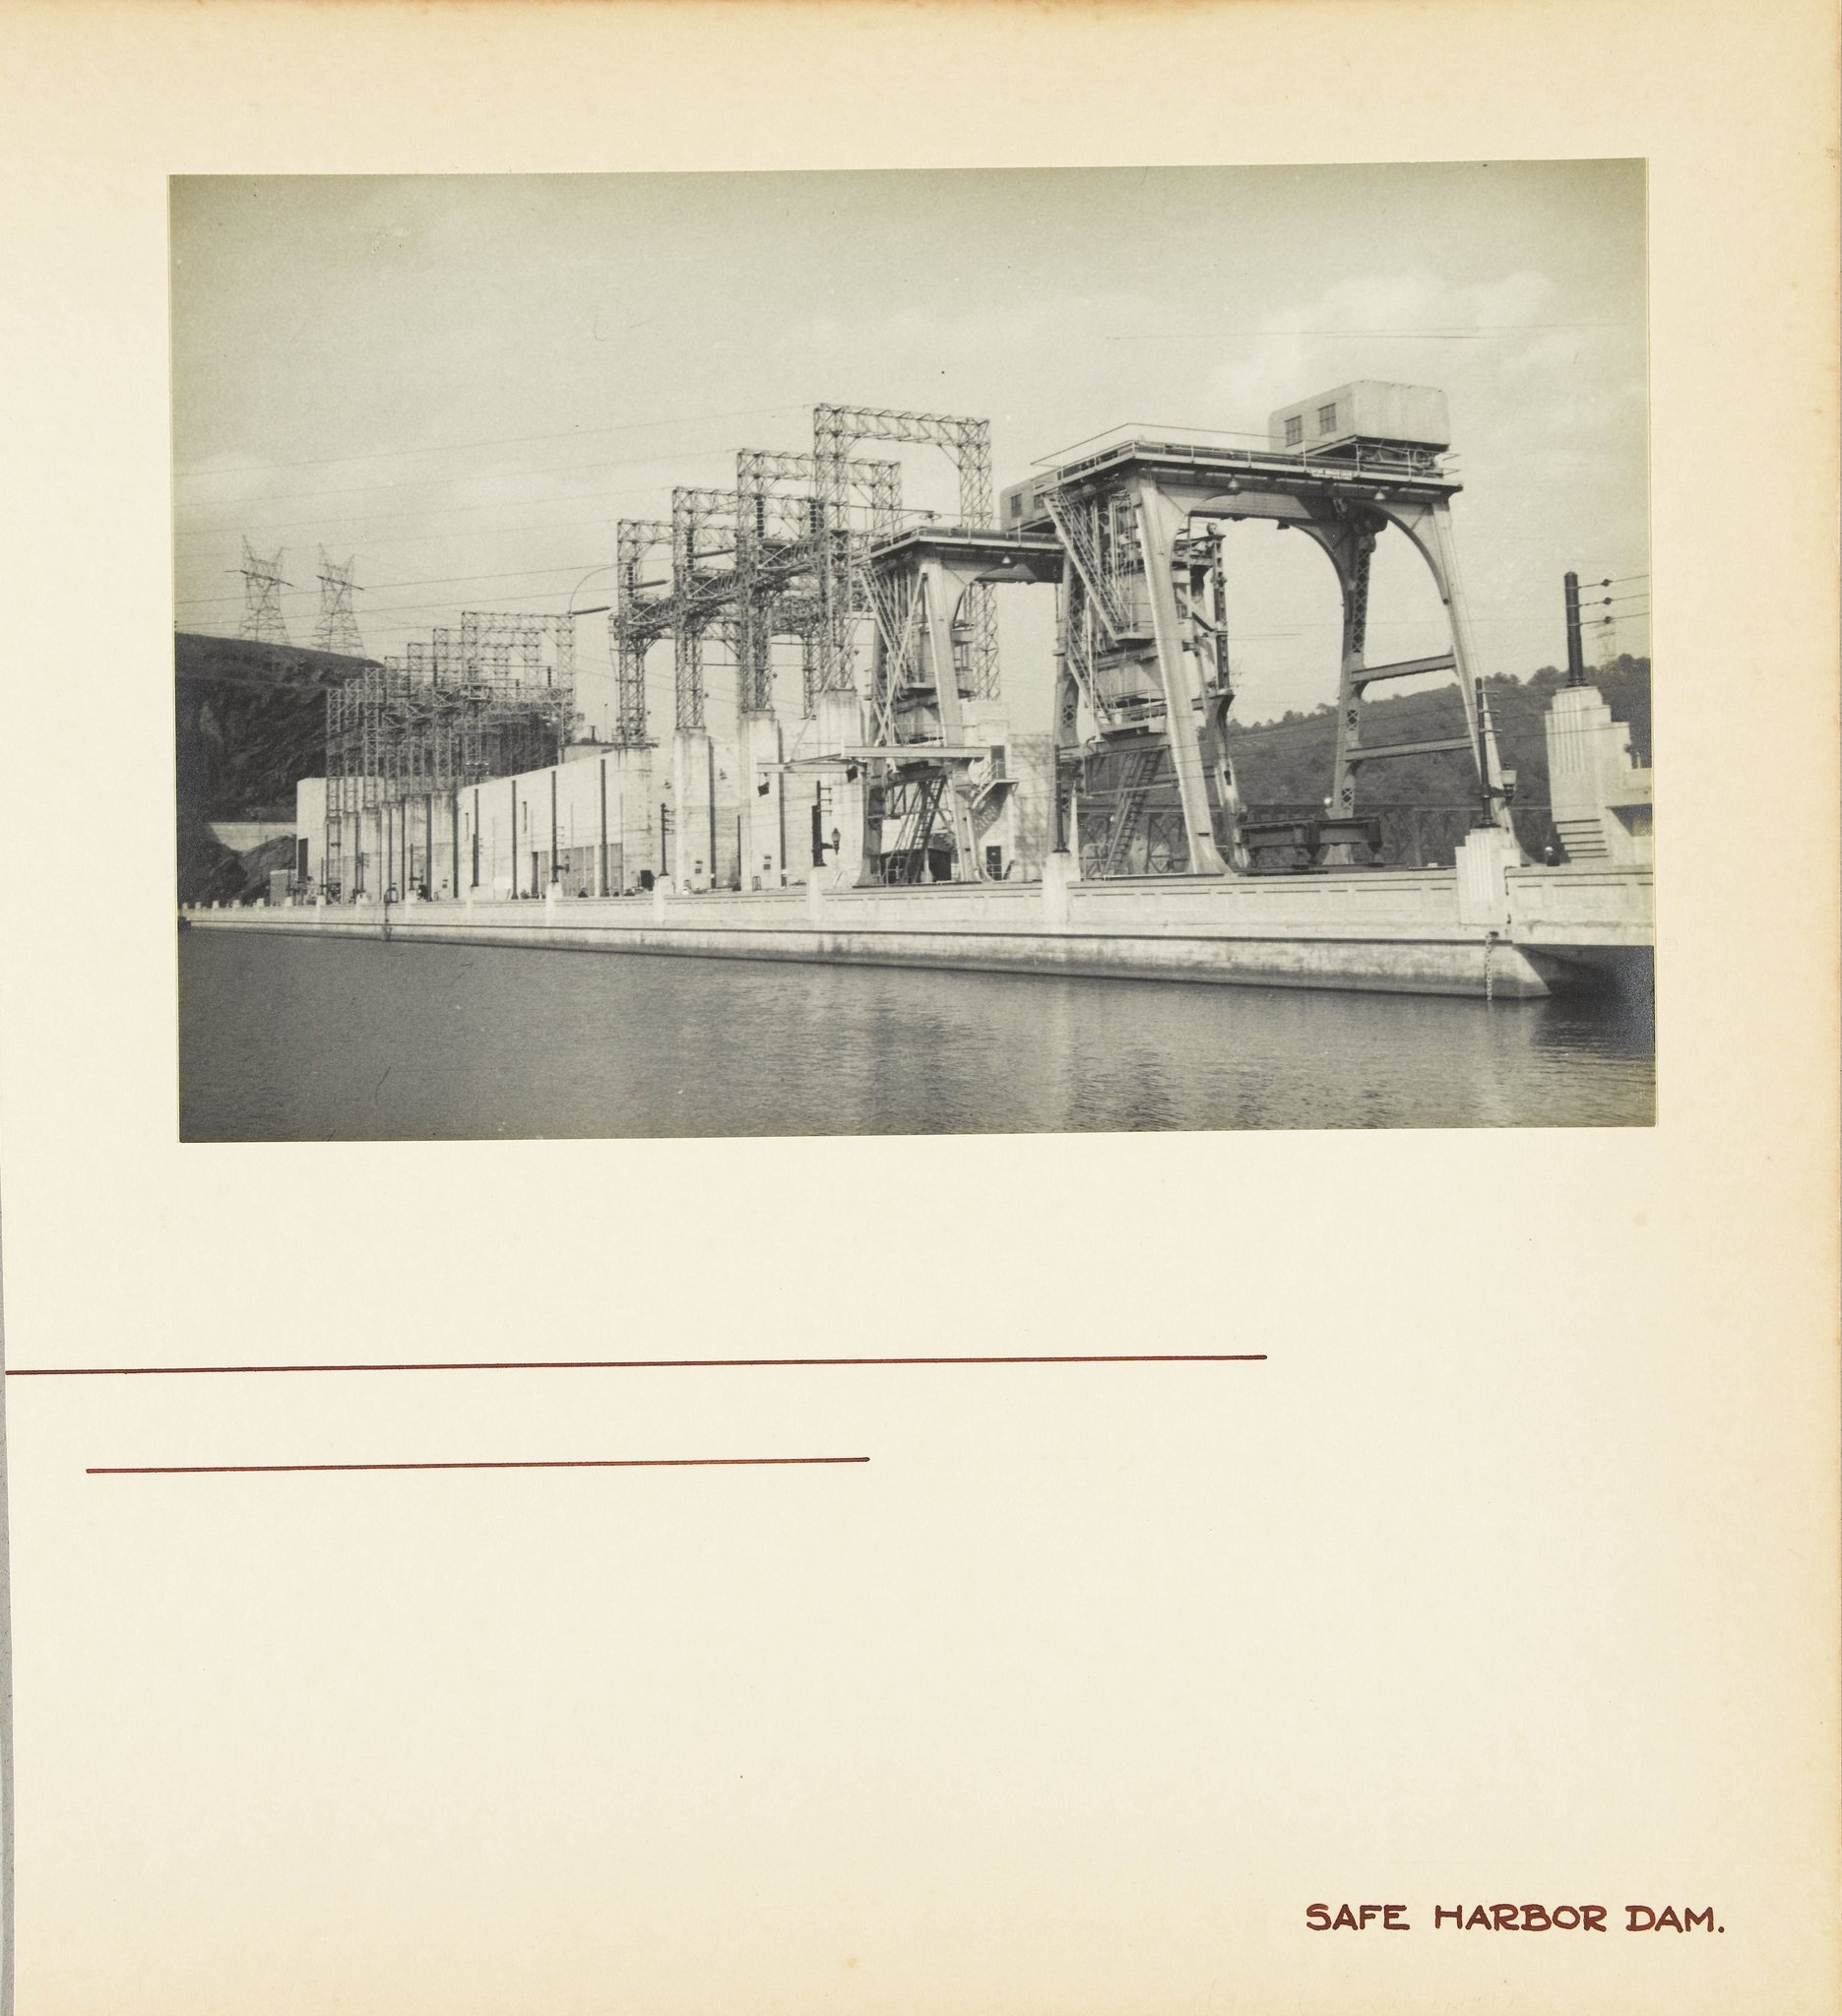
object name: photograph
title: Safe harbor dam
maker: wouter cool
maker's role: engineer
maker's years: 1877-1947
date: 1936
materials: cardboard, paper, photographic support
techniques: gelatin silver print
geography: united states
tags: dam (in canal)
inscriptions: title: ‘SAFE HARBOR DAM.’